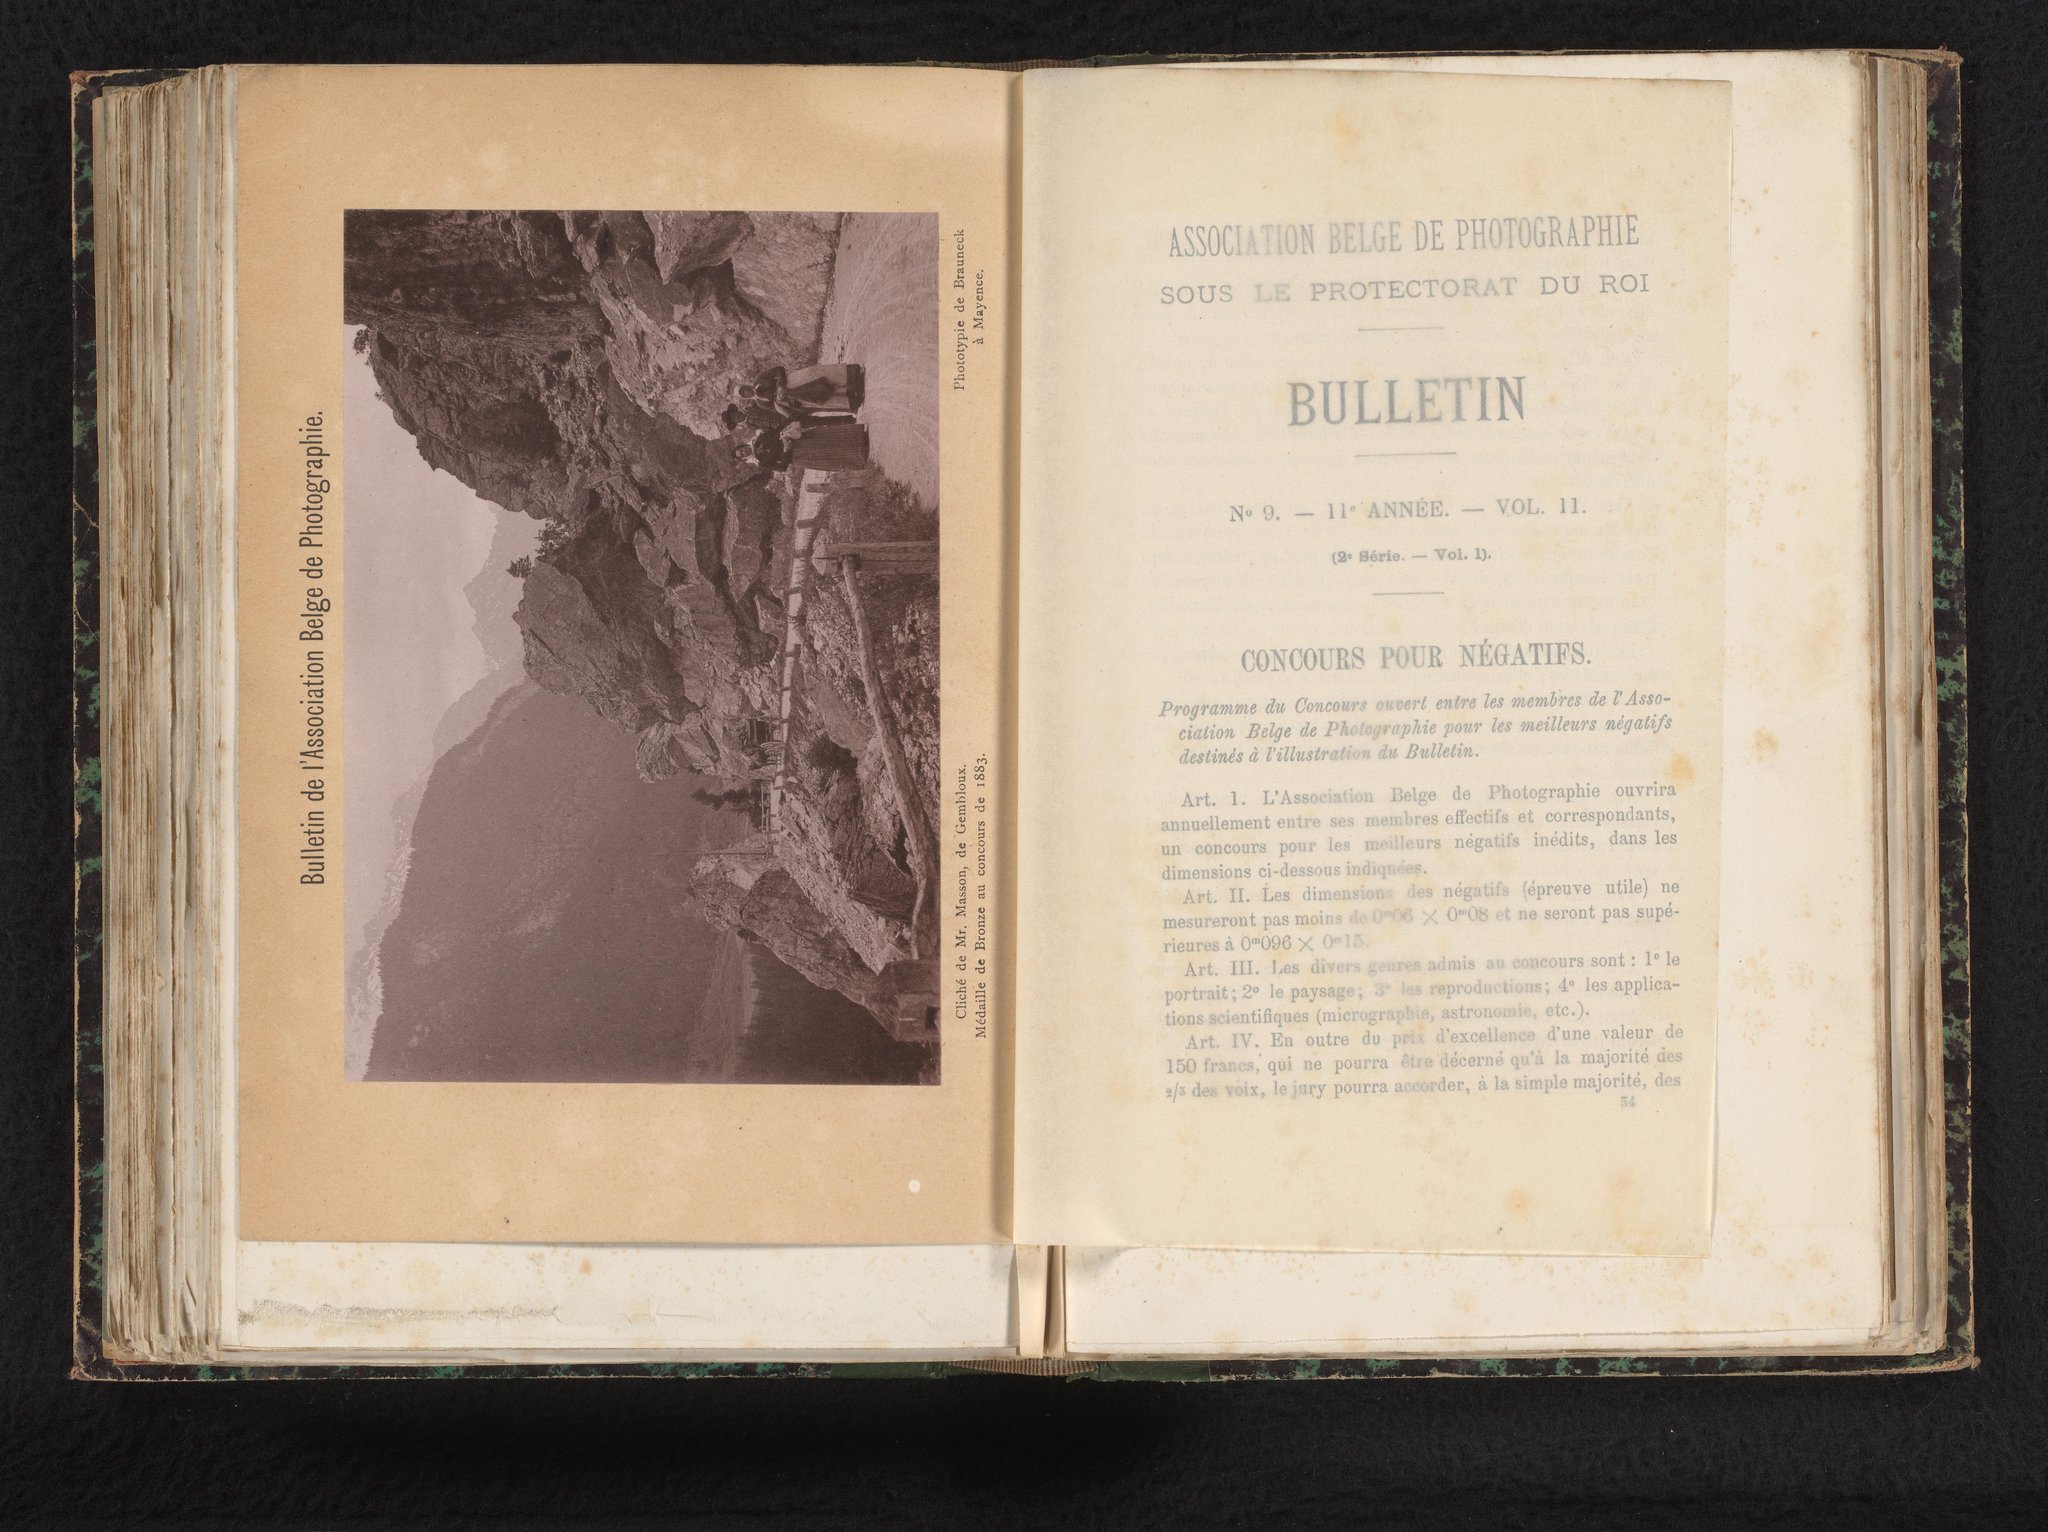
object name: page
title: Gezicht op Sankt Moritz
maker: joseph deneck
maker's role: publisher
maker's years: 1857-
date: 1883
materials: paper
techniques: woodburytype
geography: paris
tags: village, lake, mountains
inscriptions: inscription: ‘Concours de 1883/ Deuxième prix décerné à M. J. Deneck.’